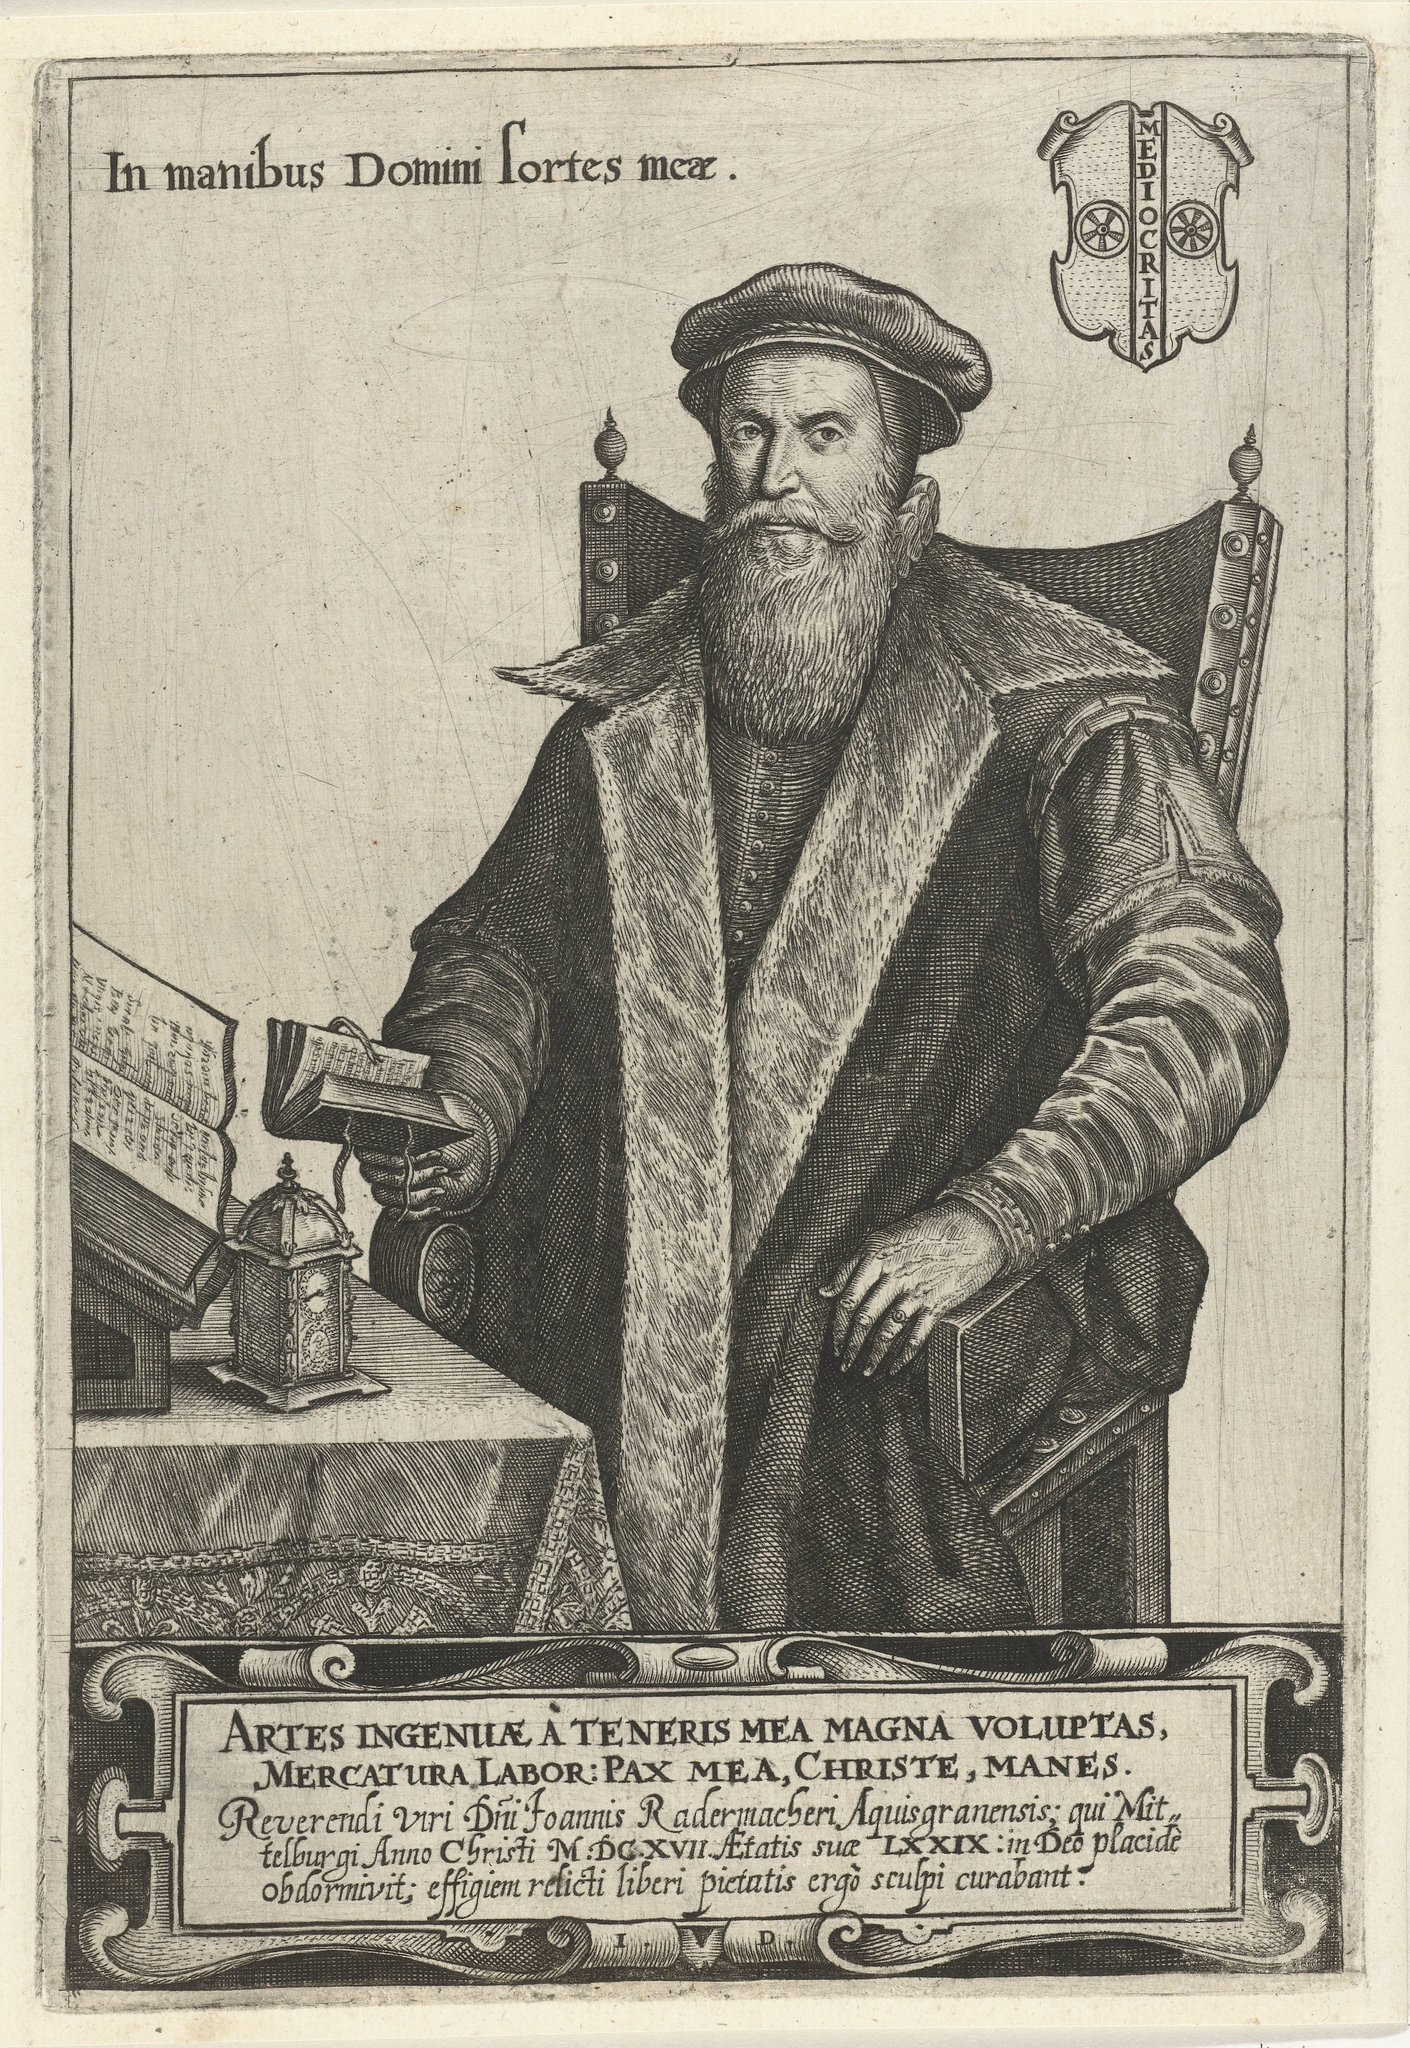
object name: print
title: Portret van Johannes Radermaker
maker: jan diricks van campen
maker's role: painter, print maker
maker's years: 1560-1622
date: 1617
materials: paper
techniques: engraving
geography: netherlands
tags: theologian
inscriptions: collector's mark: Lugt 240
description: Portret van Johannes Radermaker, zittend bij tafel met opengeslagen bijbel en klok. Onder portret cartouche met vijf regels Latijnse tekst.